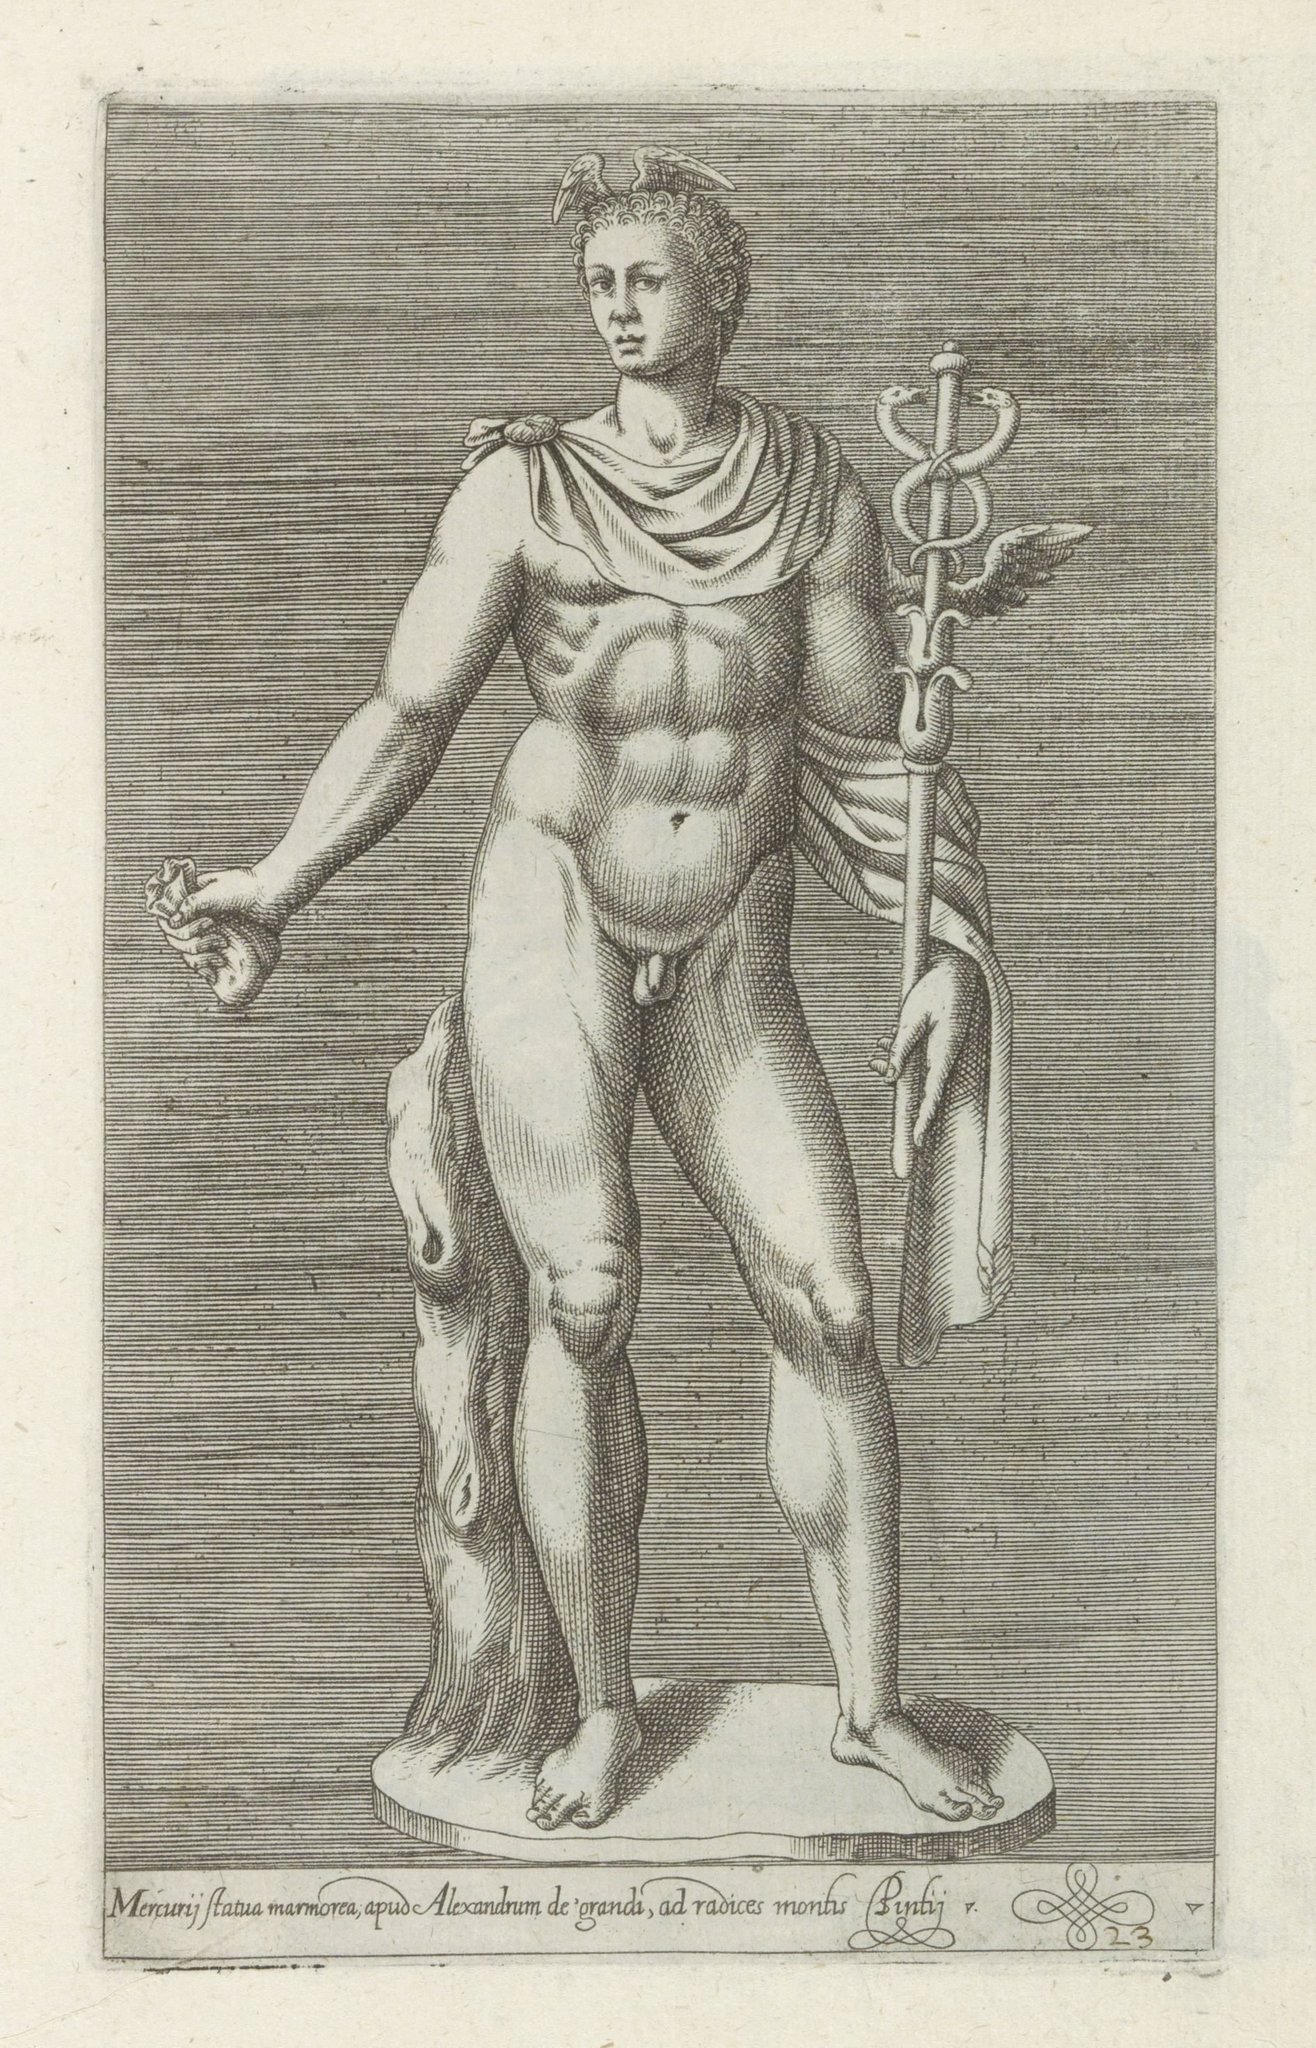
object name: print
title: Antiquarum statuarum urbis Romae quae in publicis locis visuntur icones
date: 1584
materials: paper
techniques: engraving, intaglio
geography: italy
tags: (story of) mercury (hermes), piece of sculpture, reproduction of a piece of sculpture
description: Deze prent maakt deel uit van een set van 79 prenten (+ titelprent) met voorstellingen van antieke sculpturen in Rome.